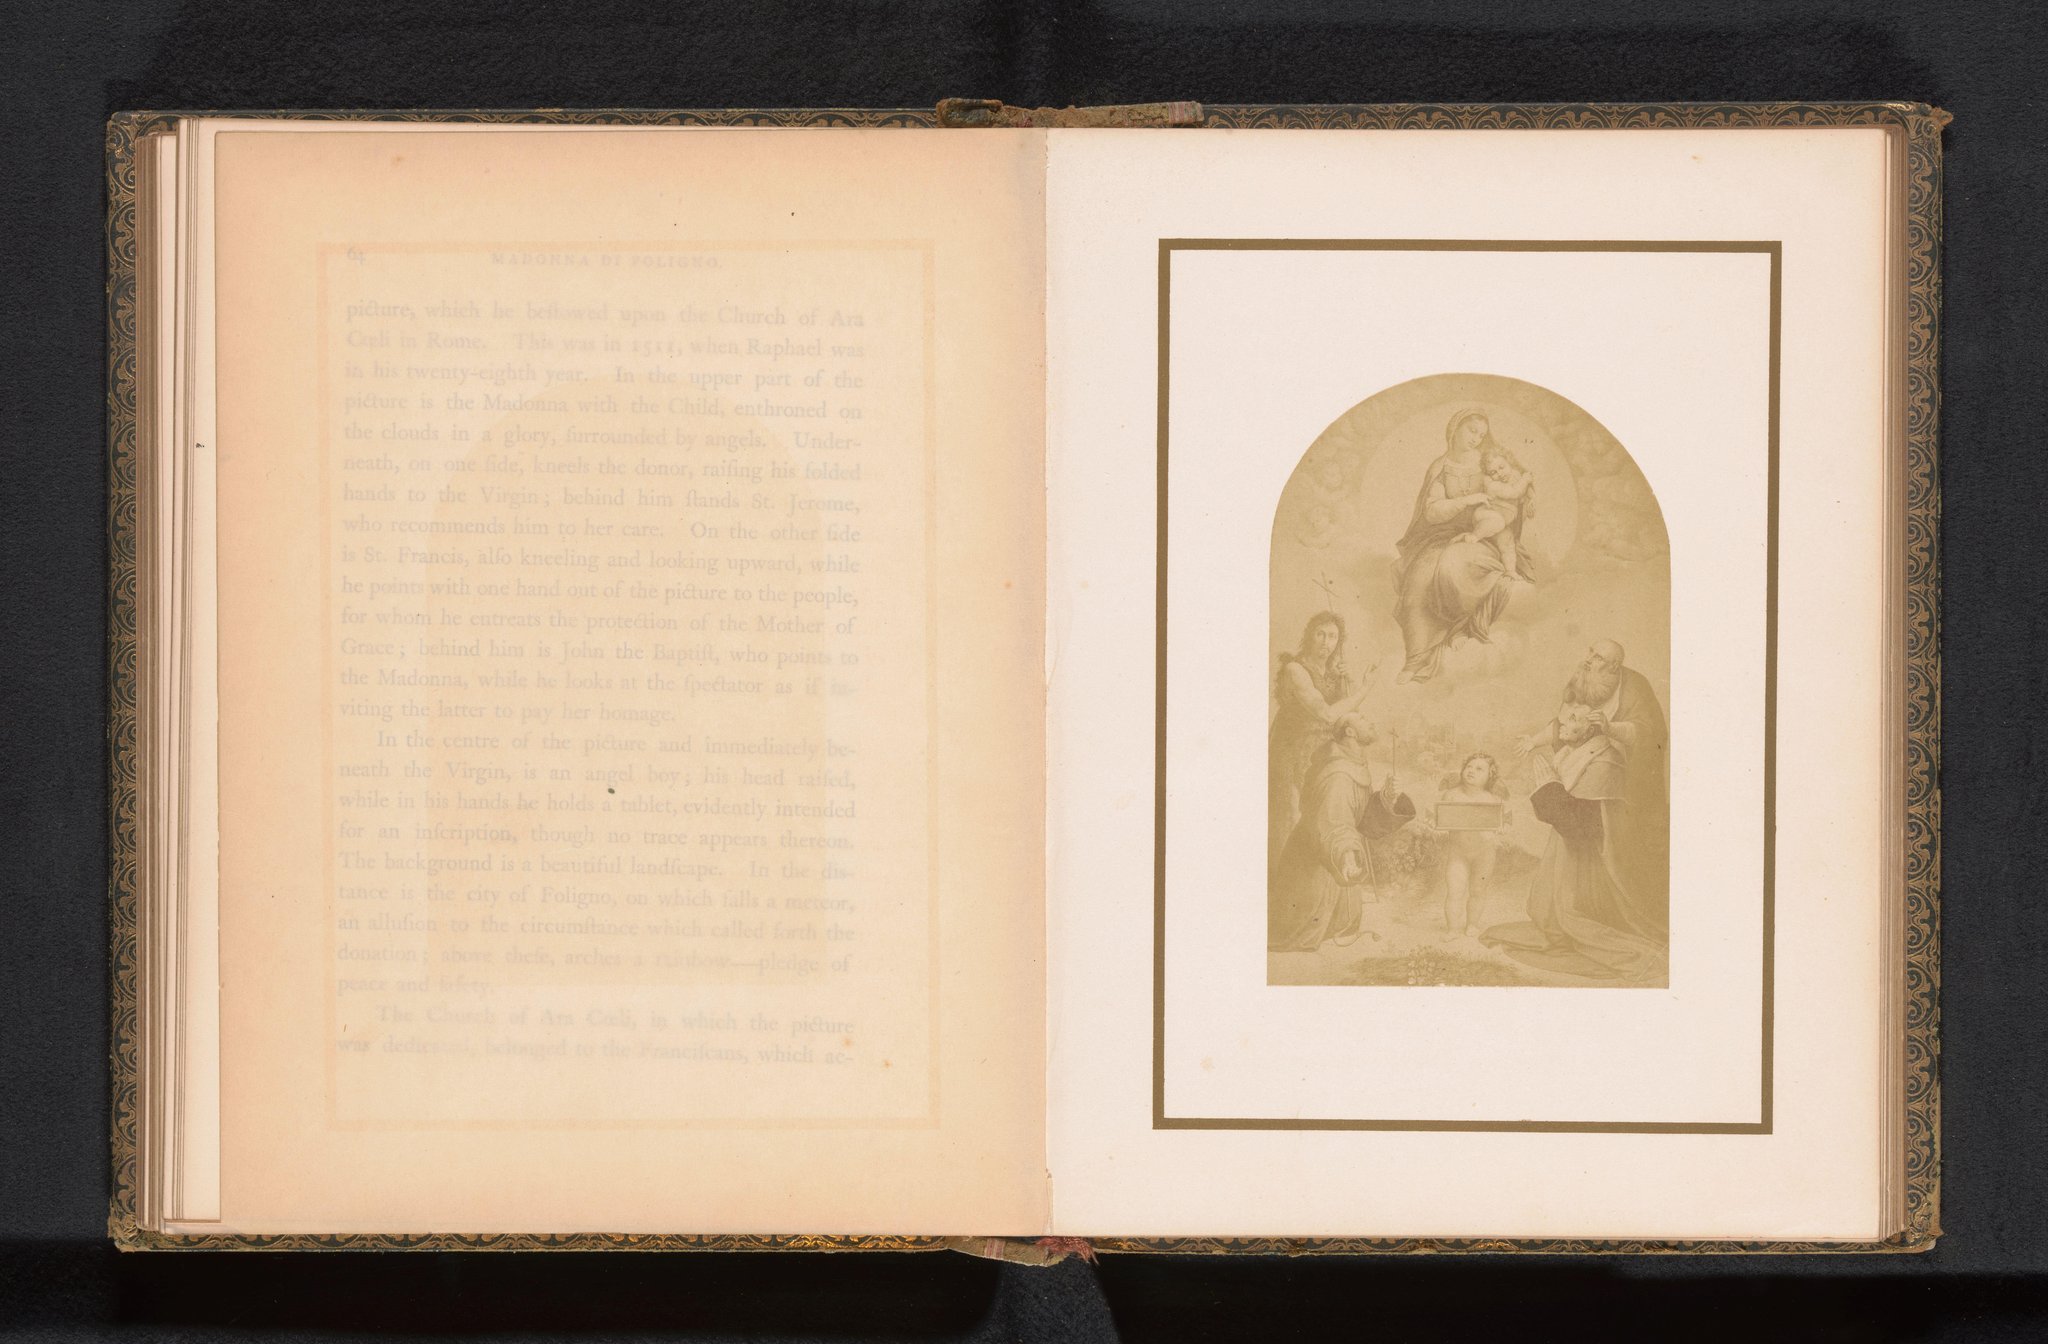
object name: photograph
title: Fotoreproductie van een prent naar een schilderij, voorstellende de Madonna van Foligno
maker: e. hufnagel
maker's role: fotograaf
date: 1855-1860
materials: photographic support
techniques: albumen print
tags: madonna (i.e. mary with the christ-child) in the air, or on the clouds